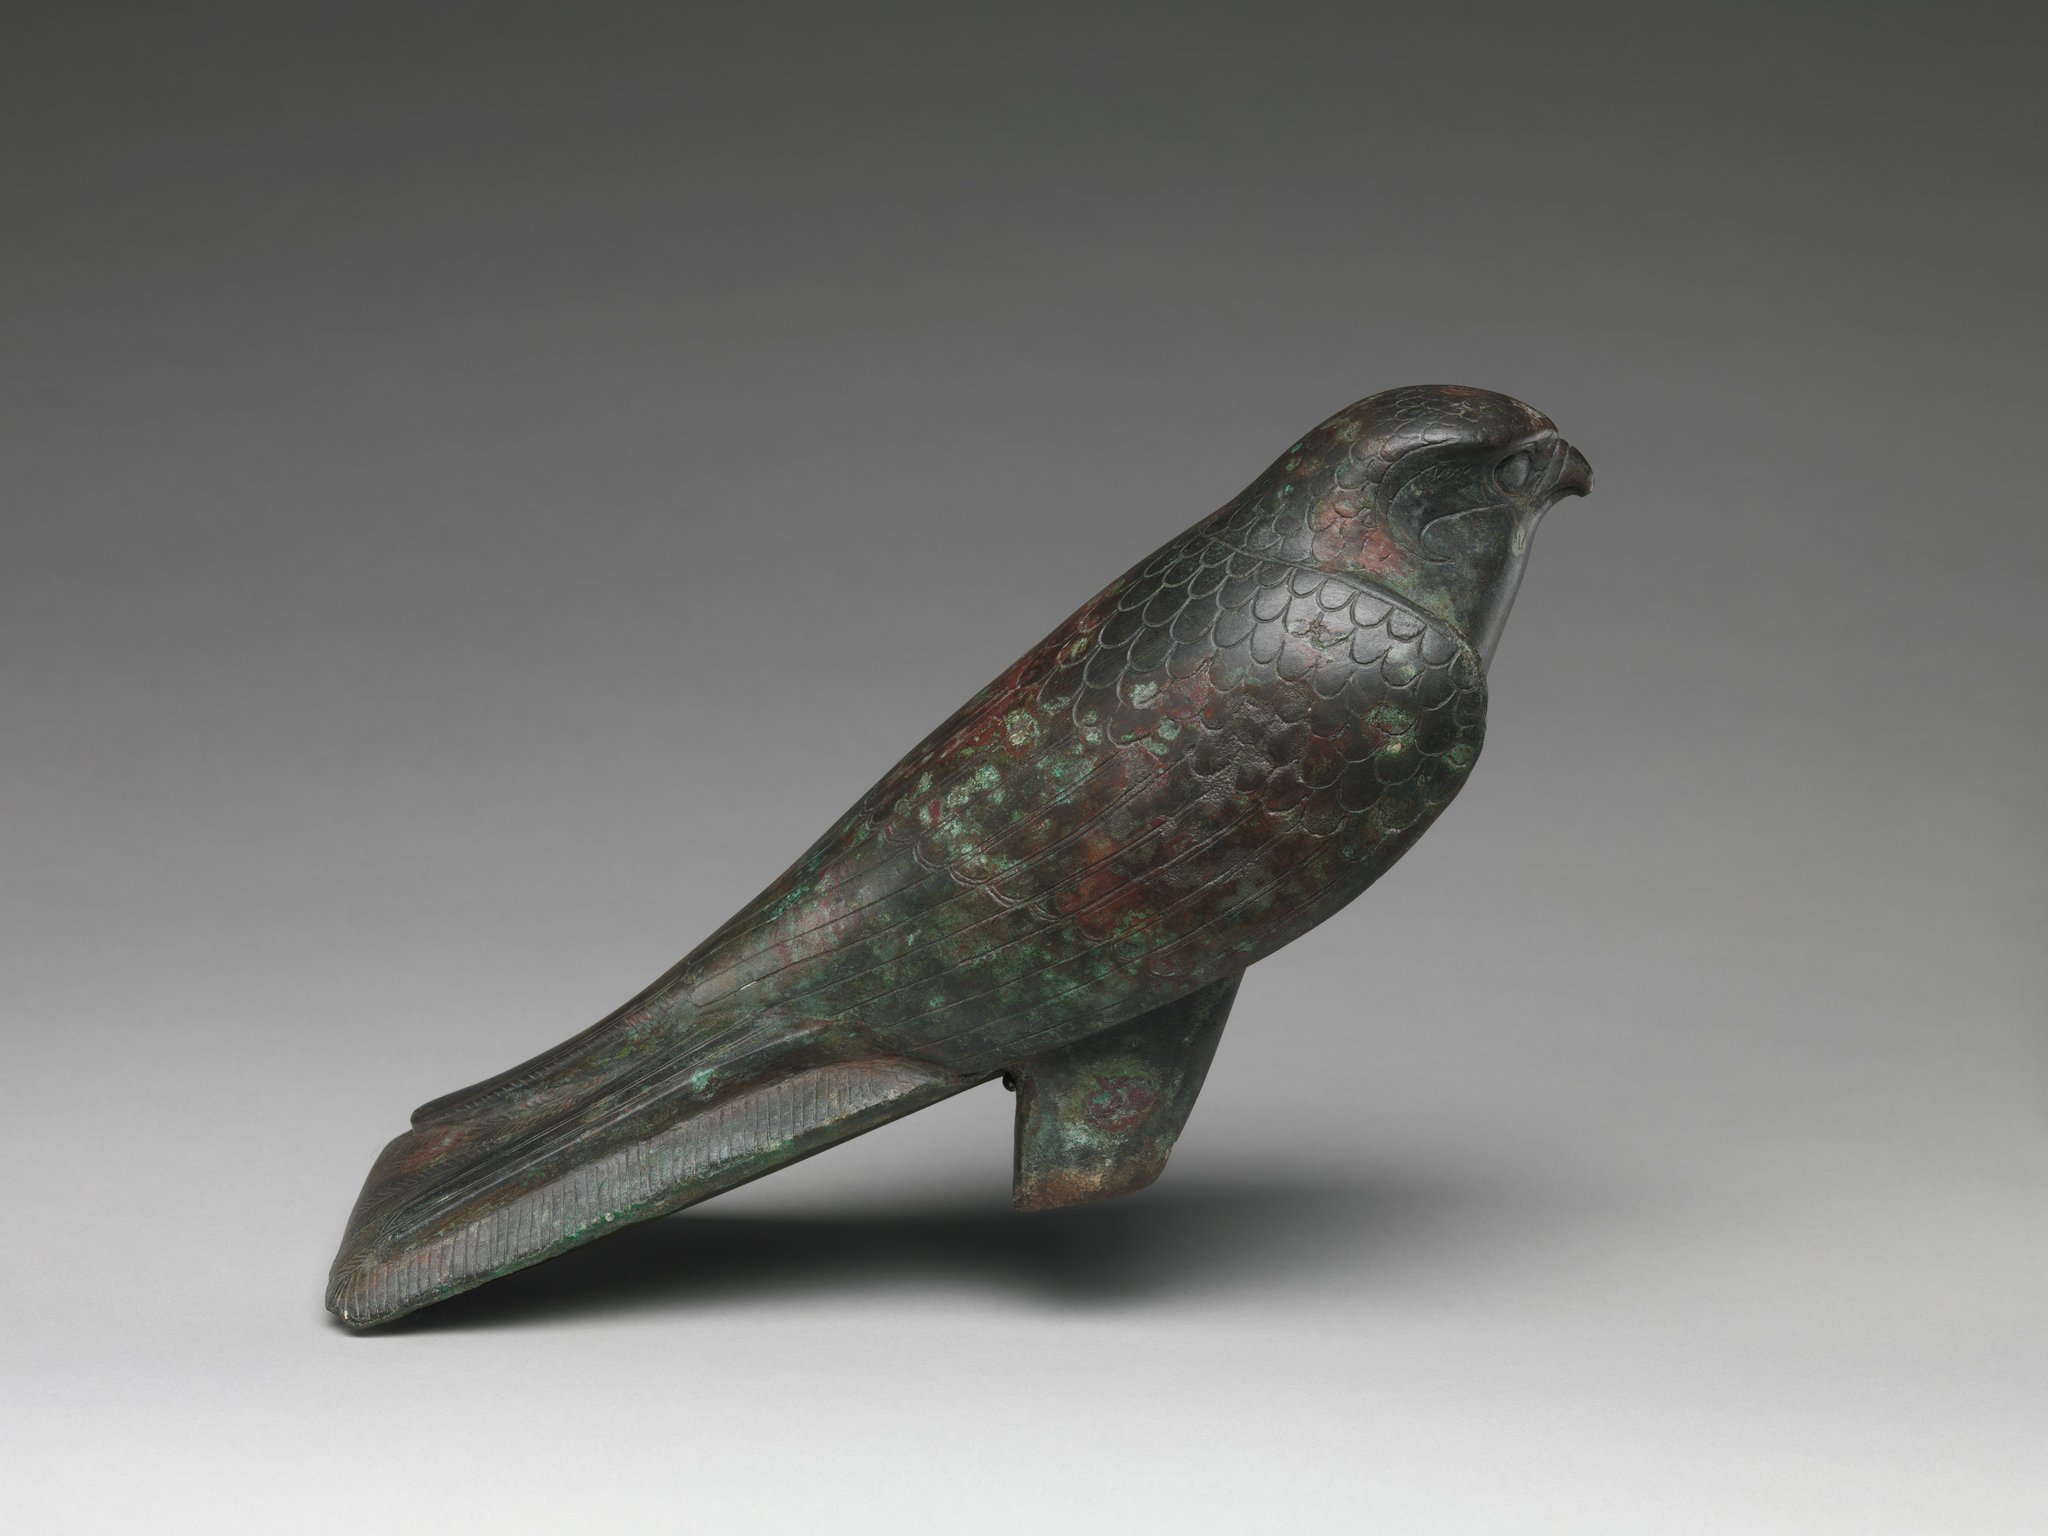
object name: statue, sarcophagus, falcon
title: Falcon statue serving as a sarcophagus for a sacred animal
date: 664-630 BCE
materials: metal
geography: egypt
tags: falcons